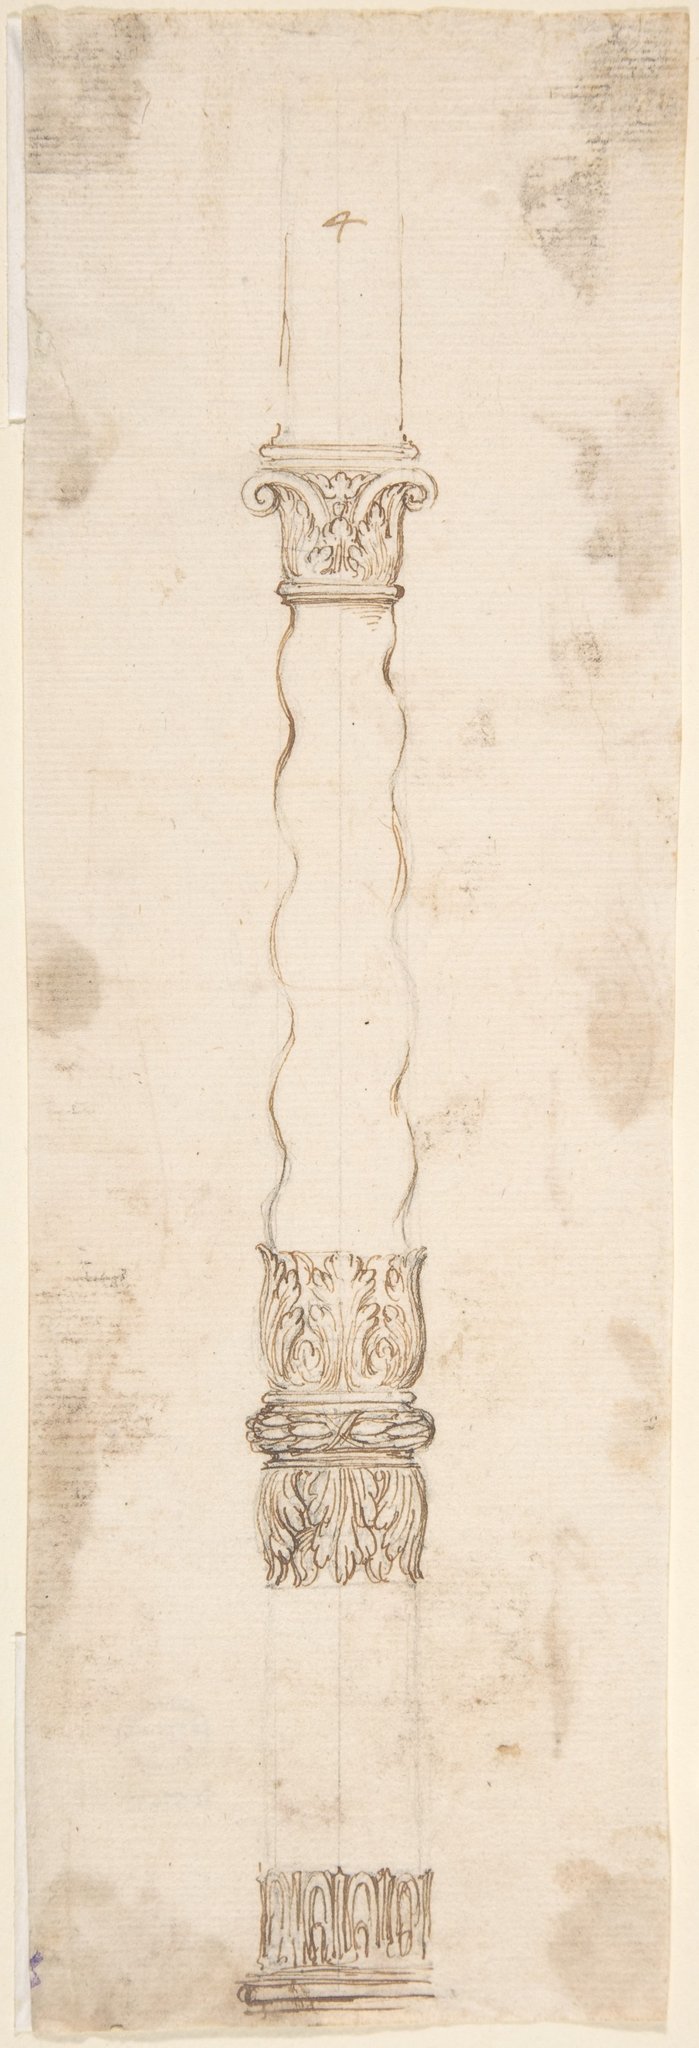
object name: drawing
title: Design for a Pillar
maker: anonymous, italian, 18th century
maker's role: artist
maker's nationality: italian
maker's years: 1700-1800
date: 1701-1800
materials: graphite, ink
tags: columns